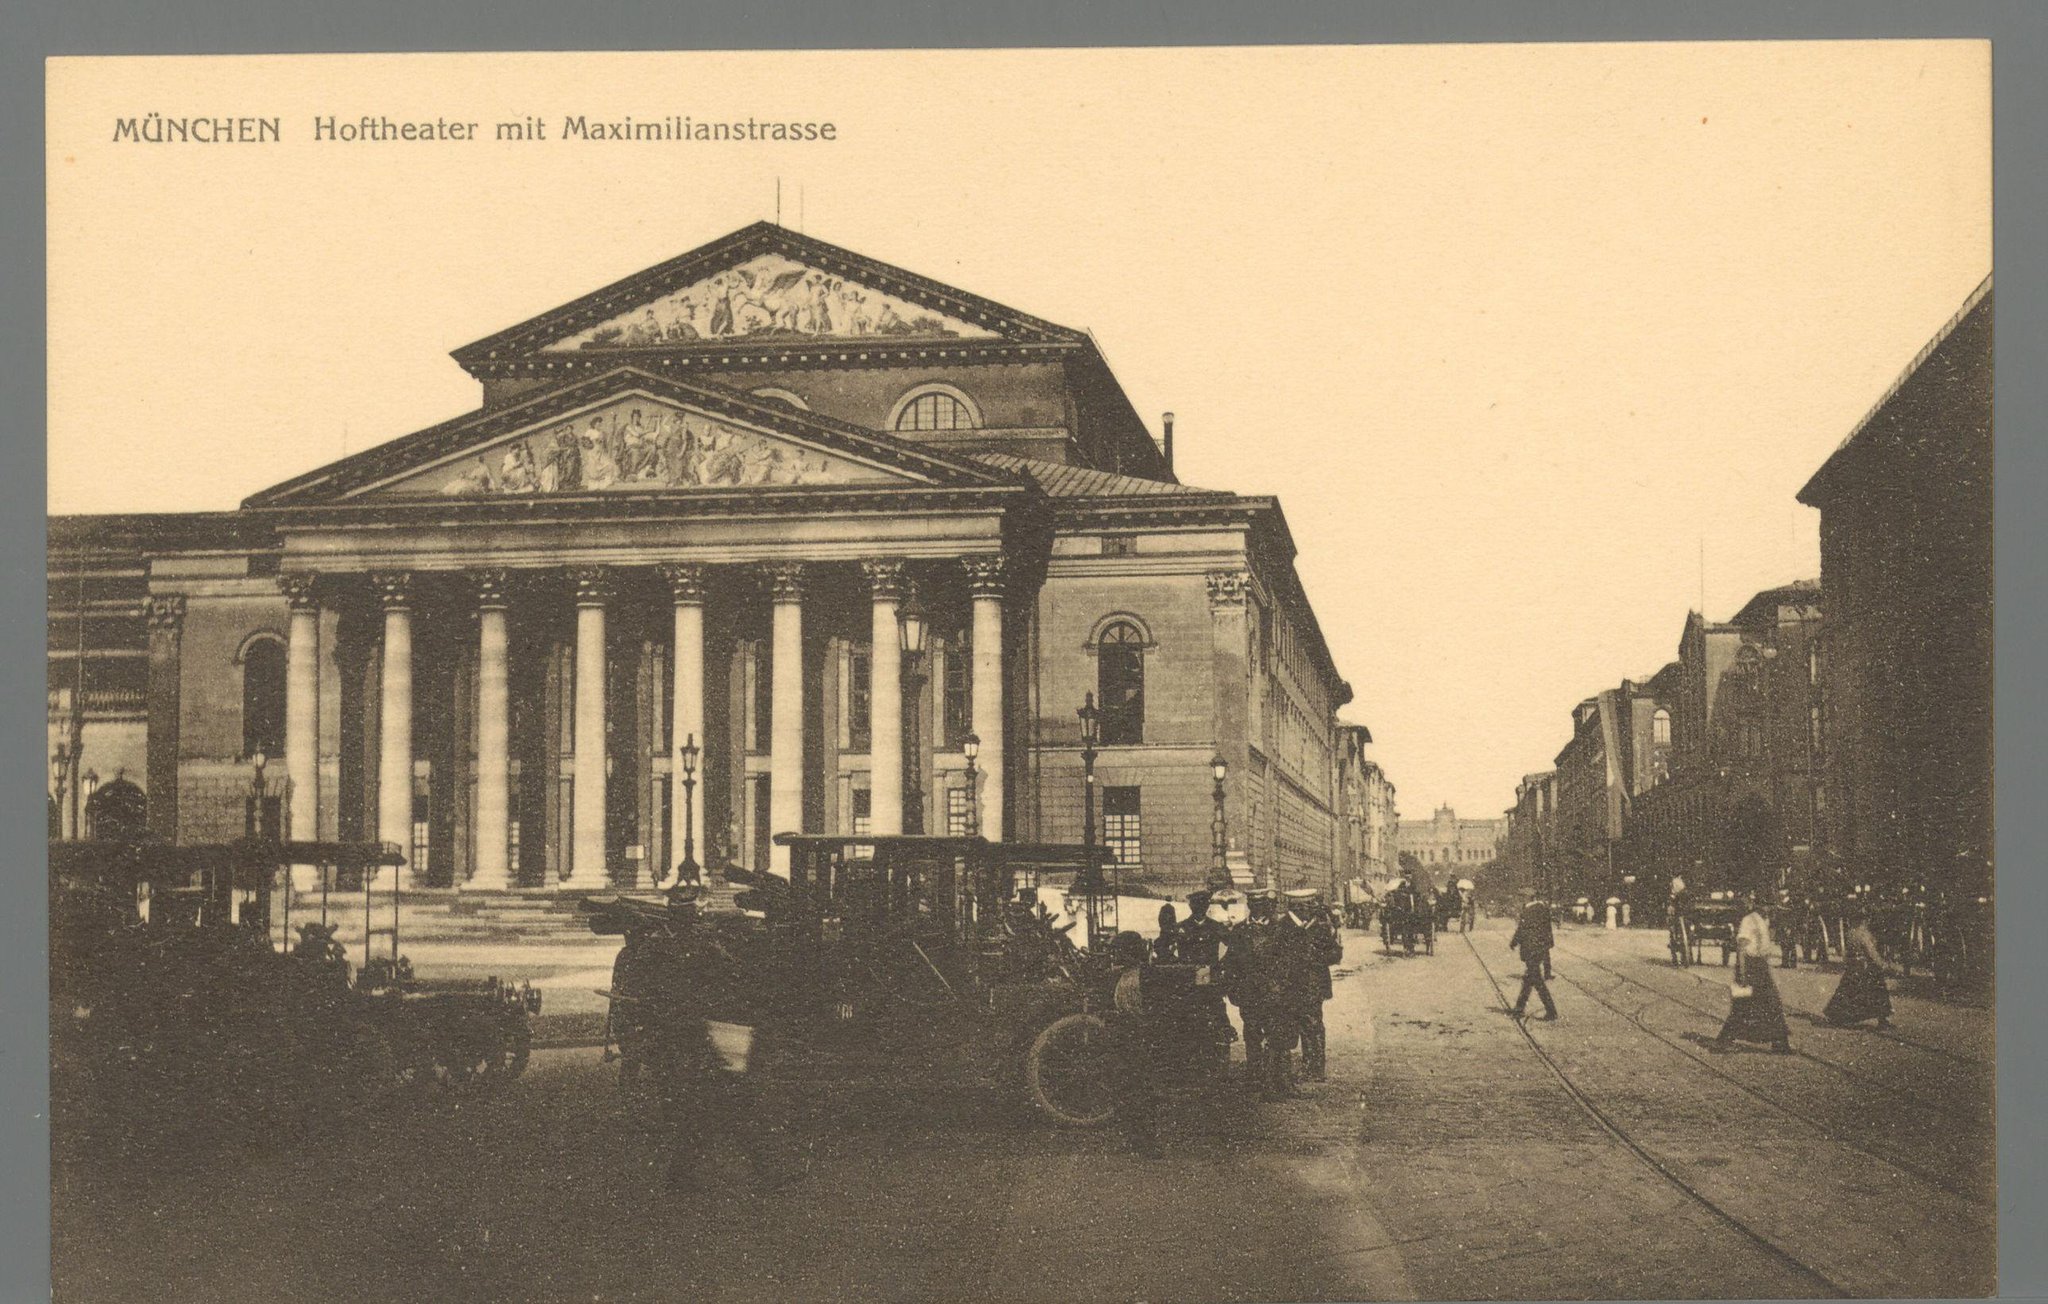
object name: photomechanical print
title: München. Hoftheater mit Maximilianstrasse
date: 1905-1930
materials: cardboard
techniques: photograph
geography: munich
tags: theatre (building), street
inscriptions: inscription: ‘W.H.D.’